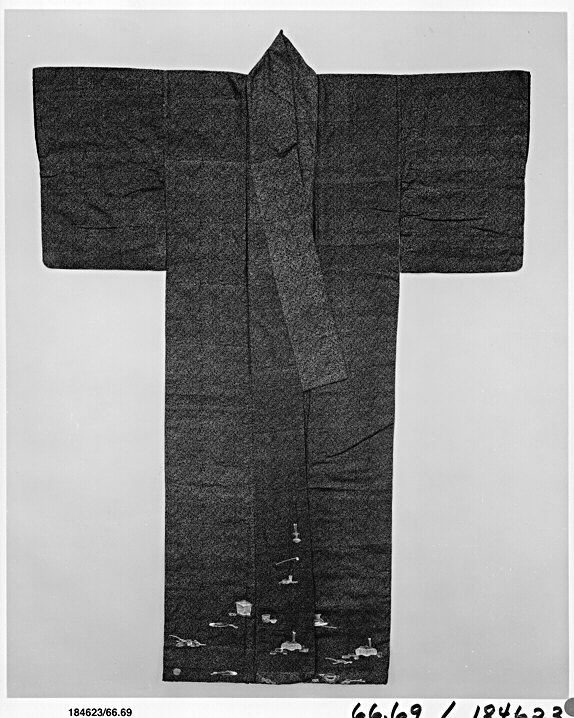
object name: kimono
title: Kosode with Pattern of Tea-Ceremony Utensils on a Small Pattern (Komon) of Auspicious Objects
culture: japanese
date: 1801-1900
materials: paste, silk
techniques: brush, dyeing, weave, resist